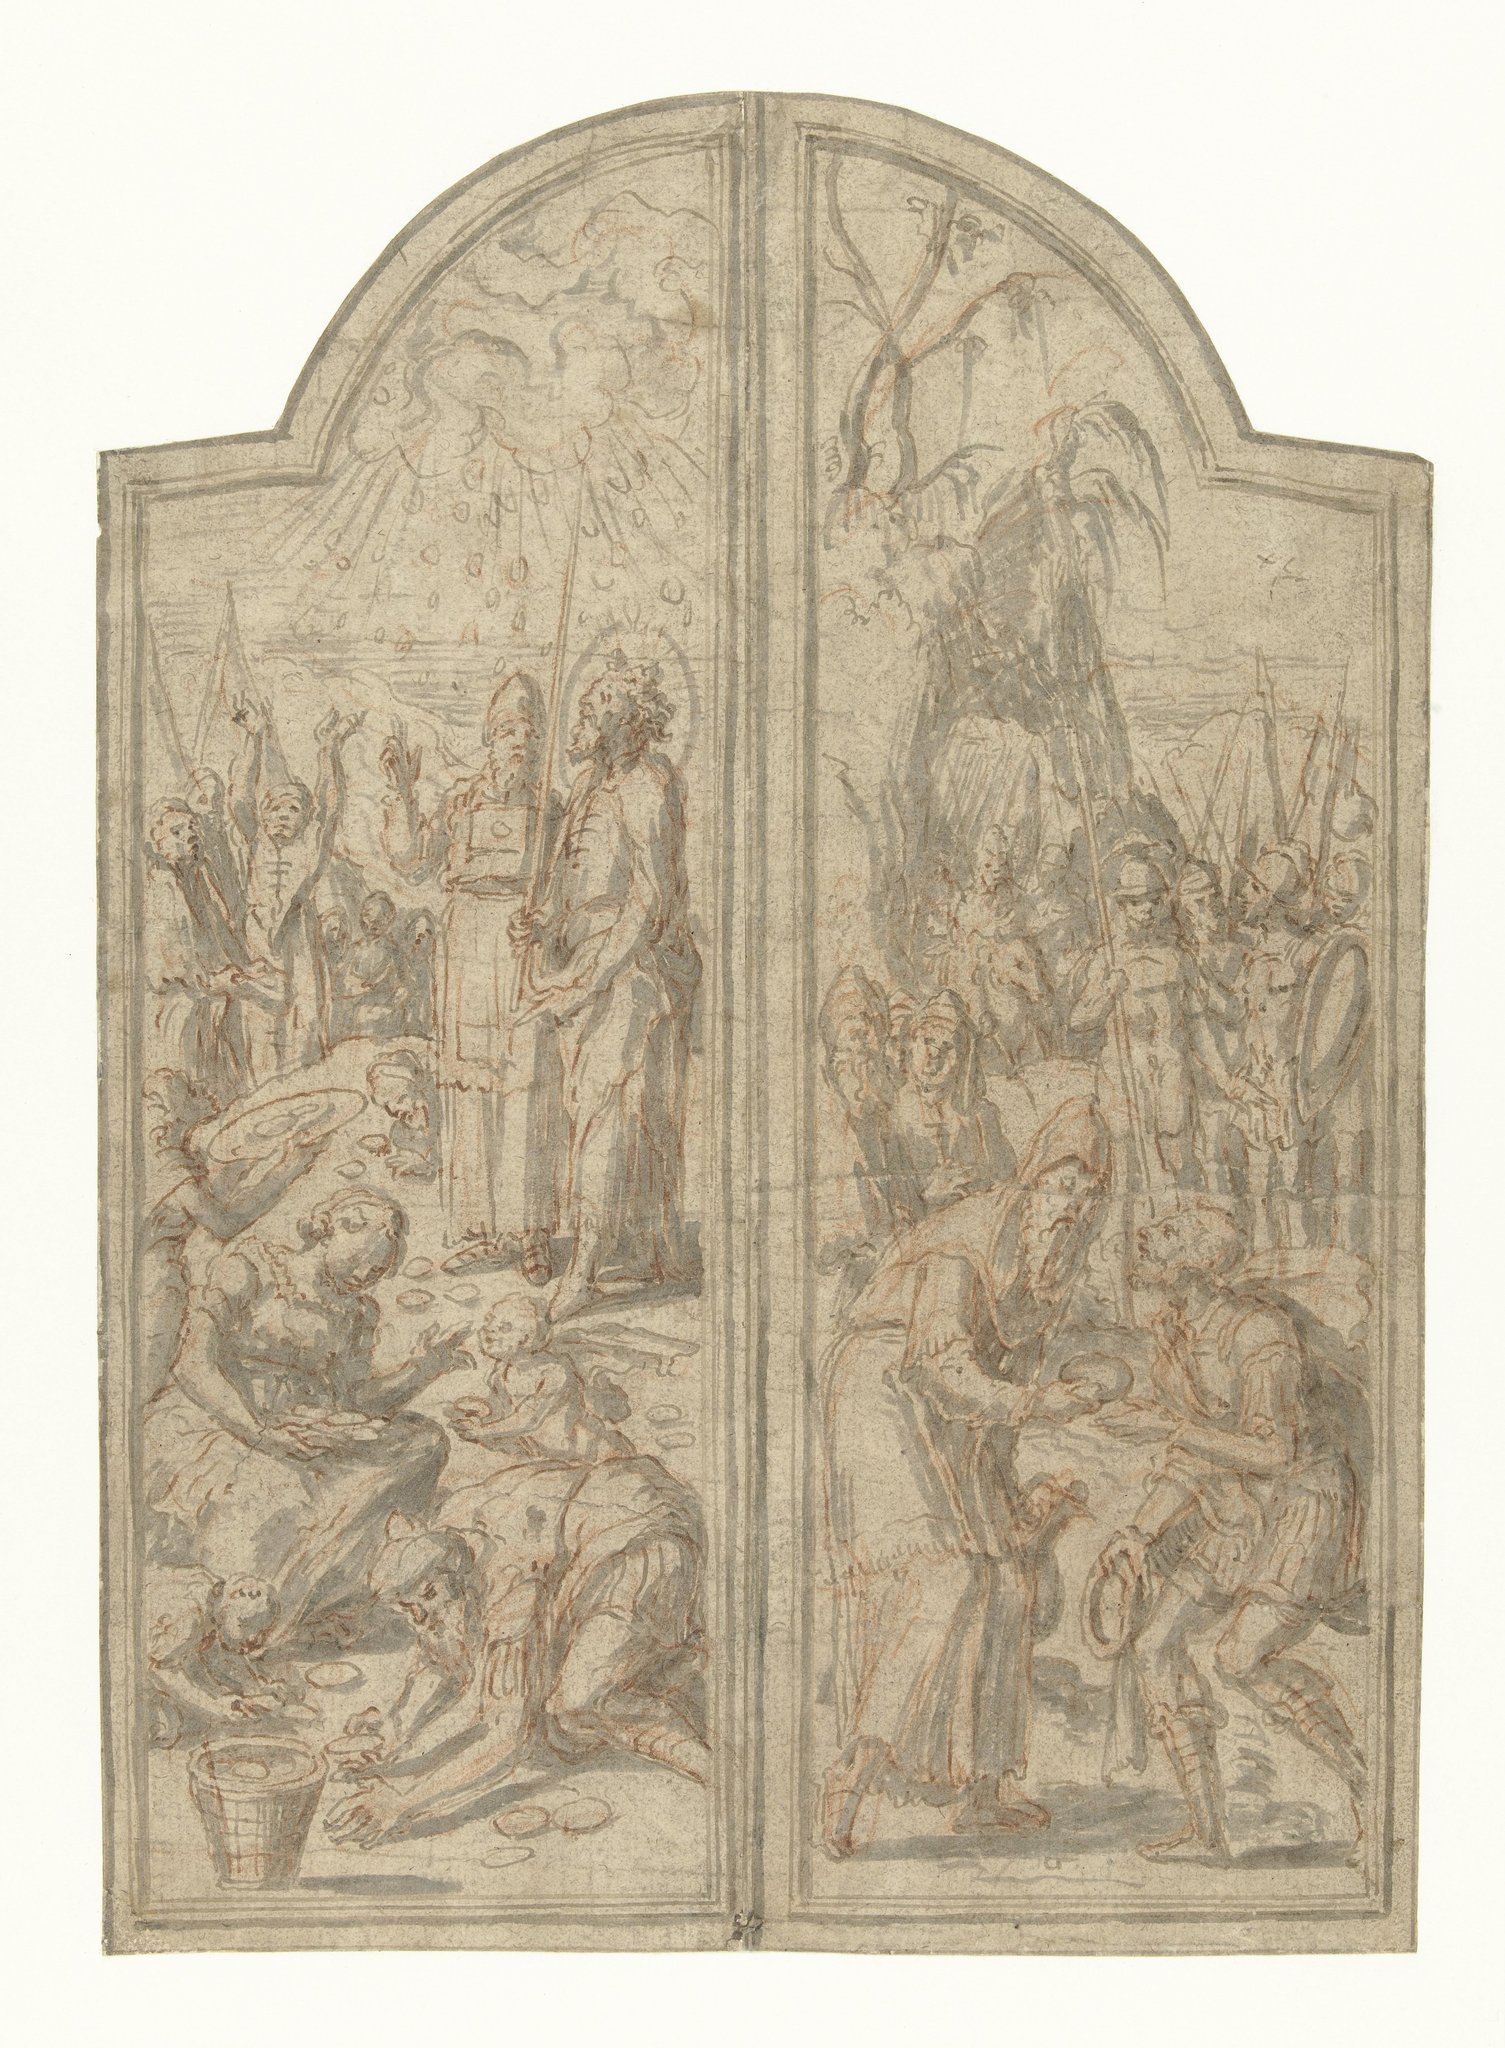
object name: drawing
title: Ontmoeting van Abraham en Melchisedek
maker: jan geritsz. deys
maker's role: painter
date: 1551-1561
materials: chalk, ink, paper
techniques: brush, pen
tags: the meeting of abraham and melchizedek, the high priest and king of salem, who brings bread and wine (genesis 14:18-20)